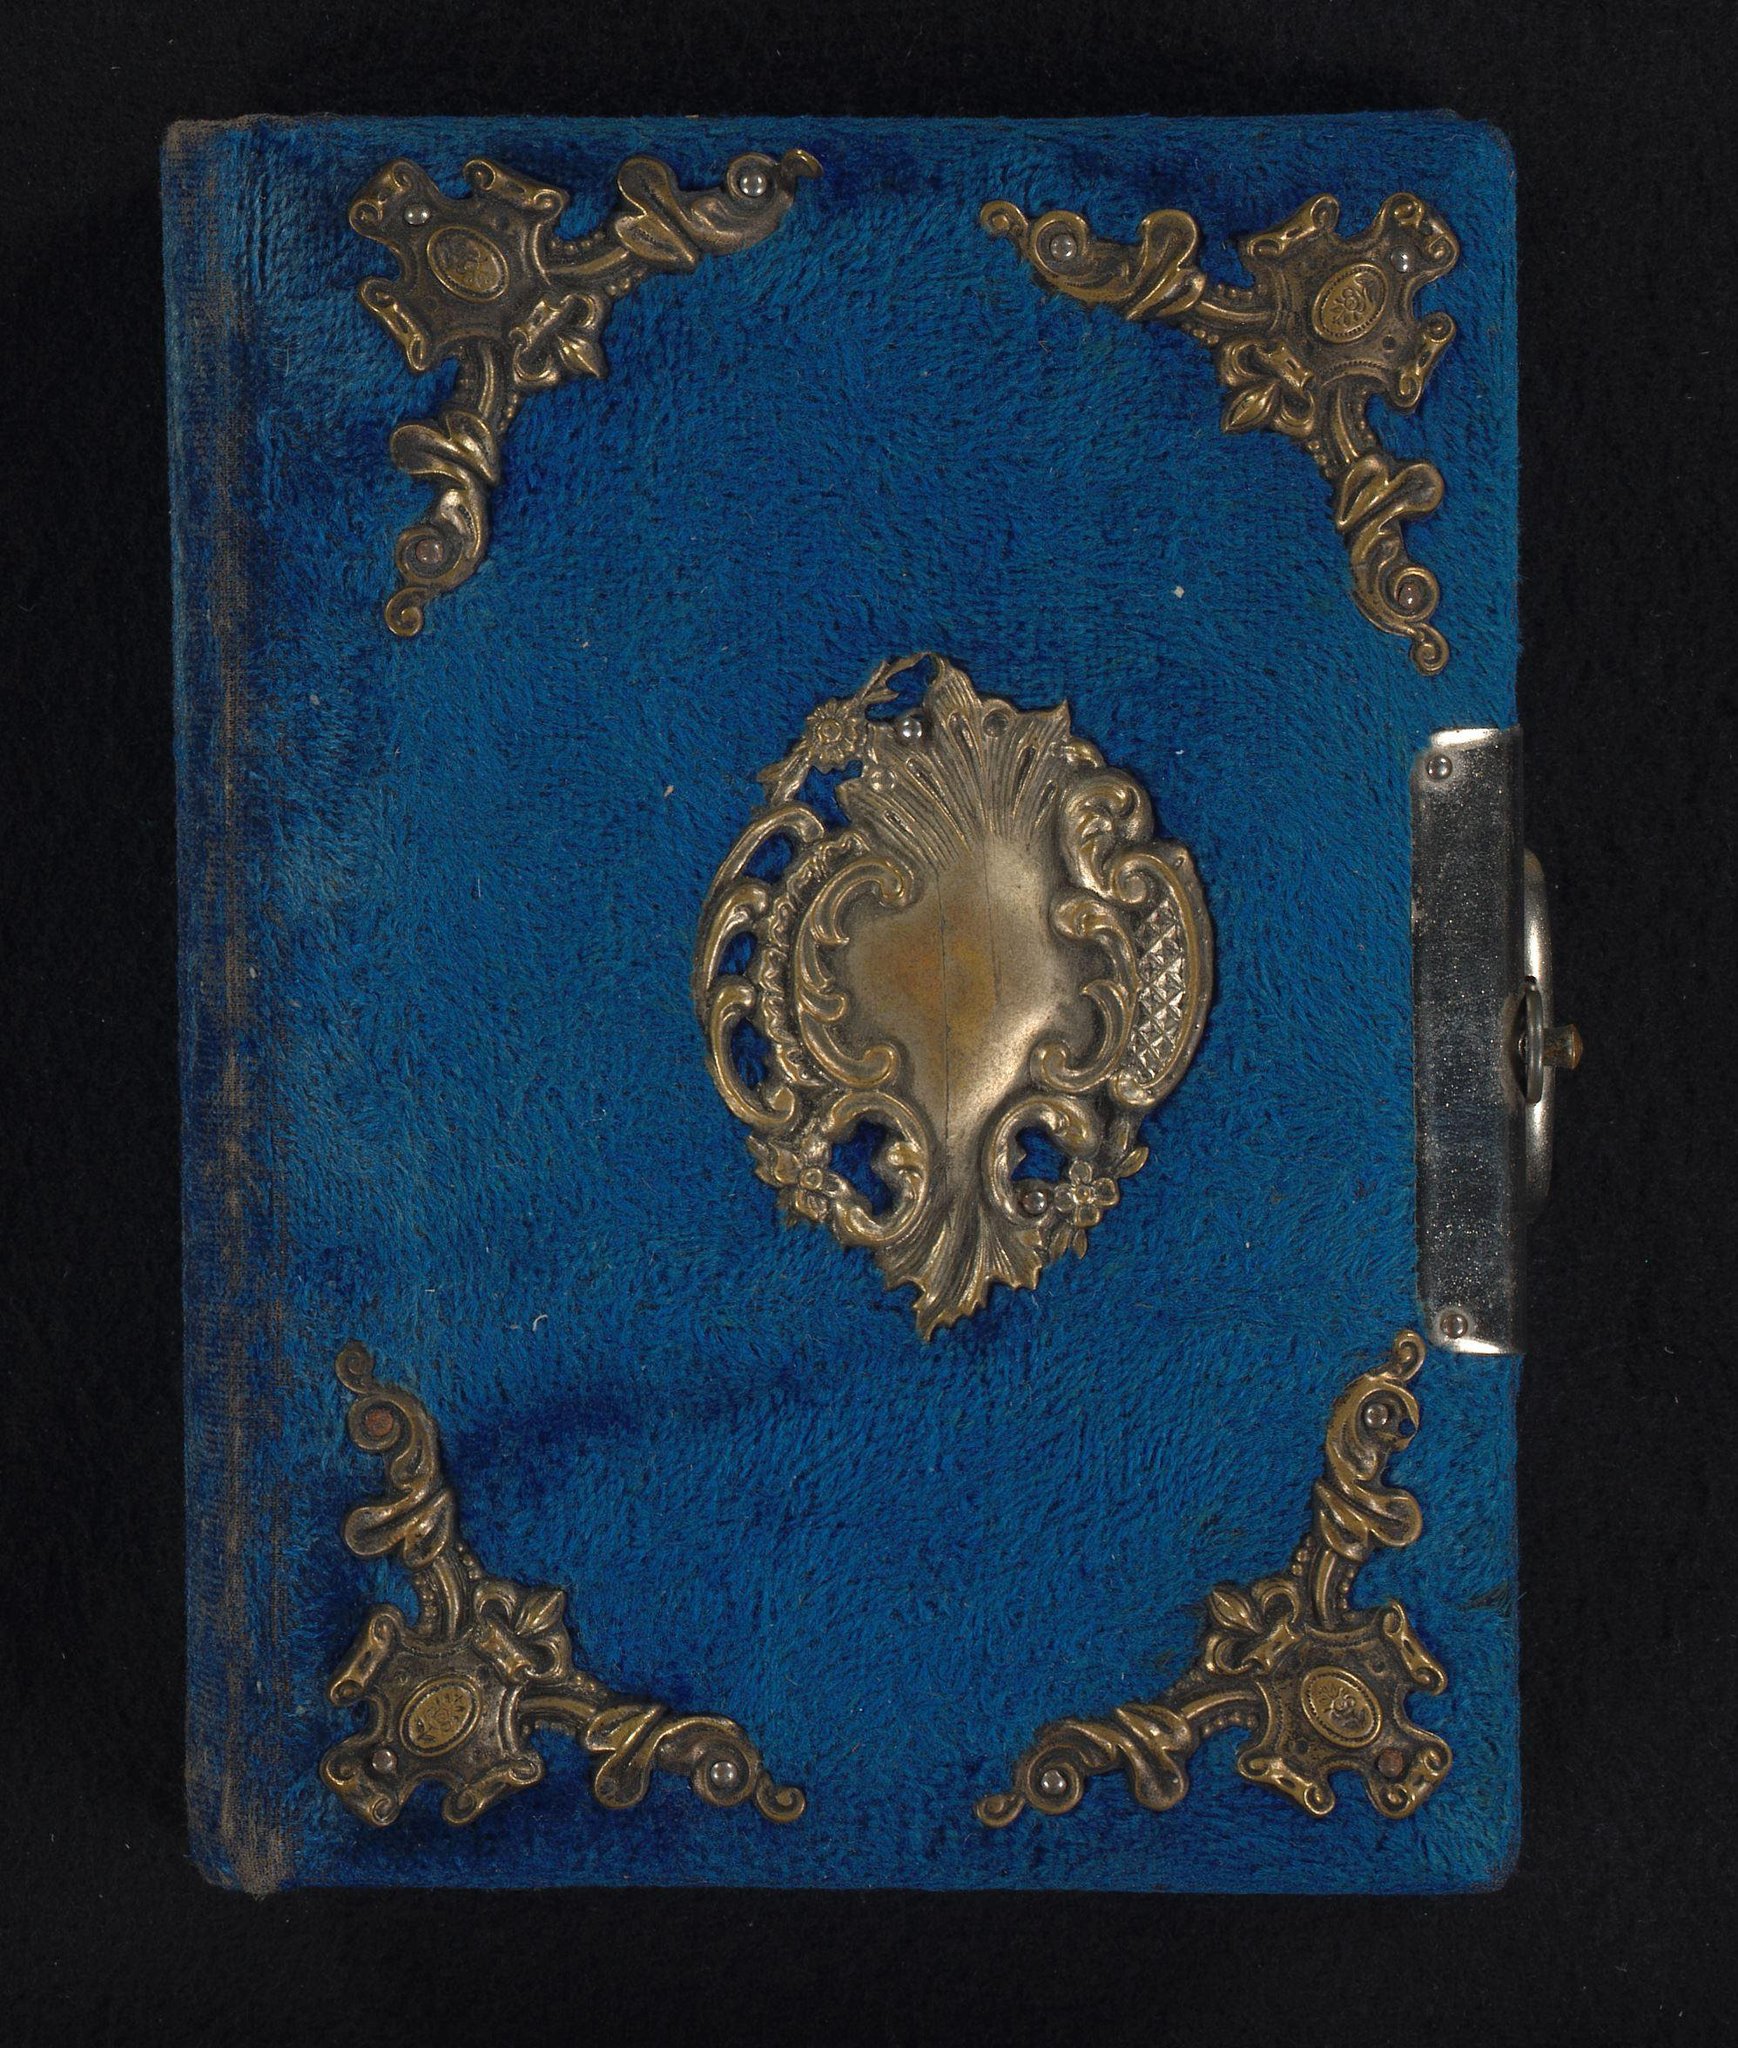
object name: slip in album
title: Frans familiealbum met 22 foto's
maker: Anonymous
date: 1860-1900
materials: cardboard, metal, paper, photographic support, textile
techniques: albumen print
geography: france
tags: historical persons - bb - woman, child, historical persons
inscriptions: collector's mark: ‘DIENST/ VERSPREIDE/ RIJKSKOLLEKTIES/ (...) A 801’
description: Fotoalbum met 22 pagina's met 22 cartes-de-visite in met gouden lijnen omkaderde passe-partouts. Afgebeeld zijn portretten van onbekende mannen, vrouwen en kinderen. De foto's zijn gemaakt door verschillende Franse fotografen. Van 8 foto's is de fotograaf anoniem. Mogelijk bevindt zich op de achterzijde van sommige van deze cartes-de-visite informatie over de vervaardiger, maar deze foto's konden niet allemaal uit het album worden gehaald.